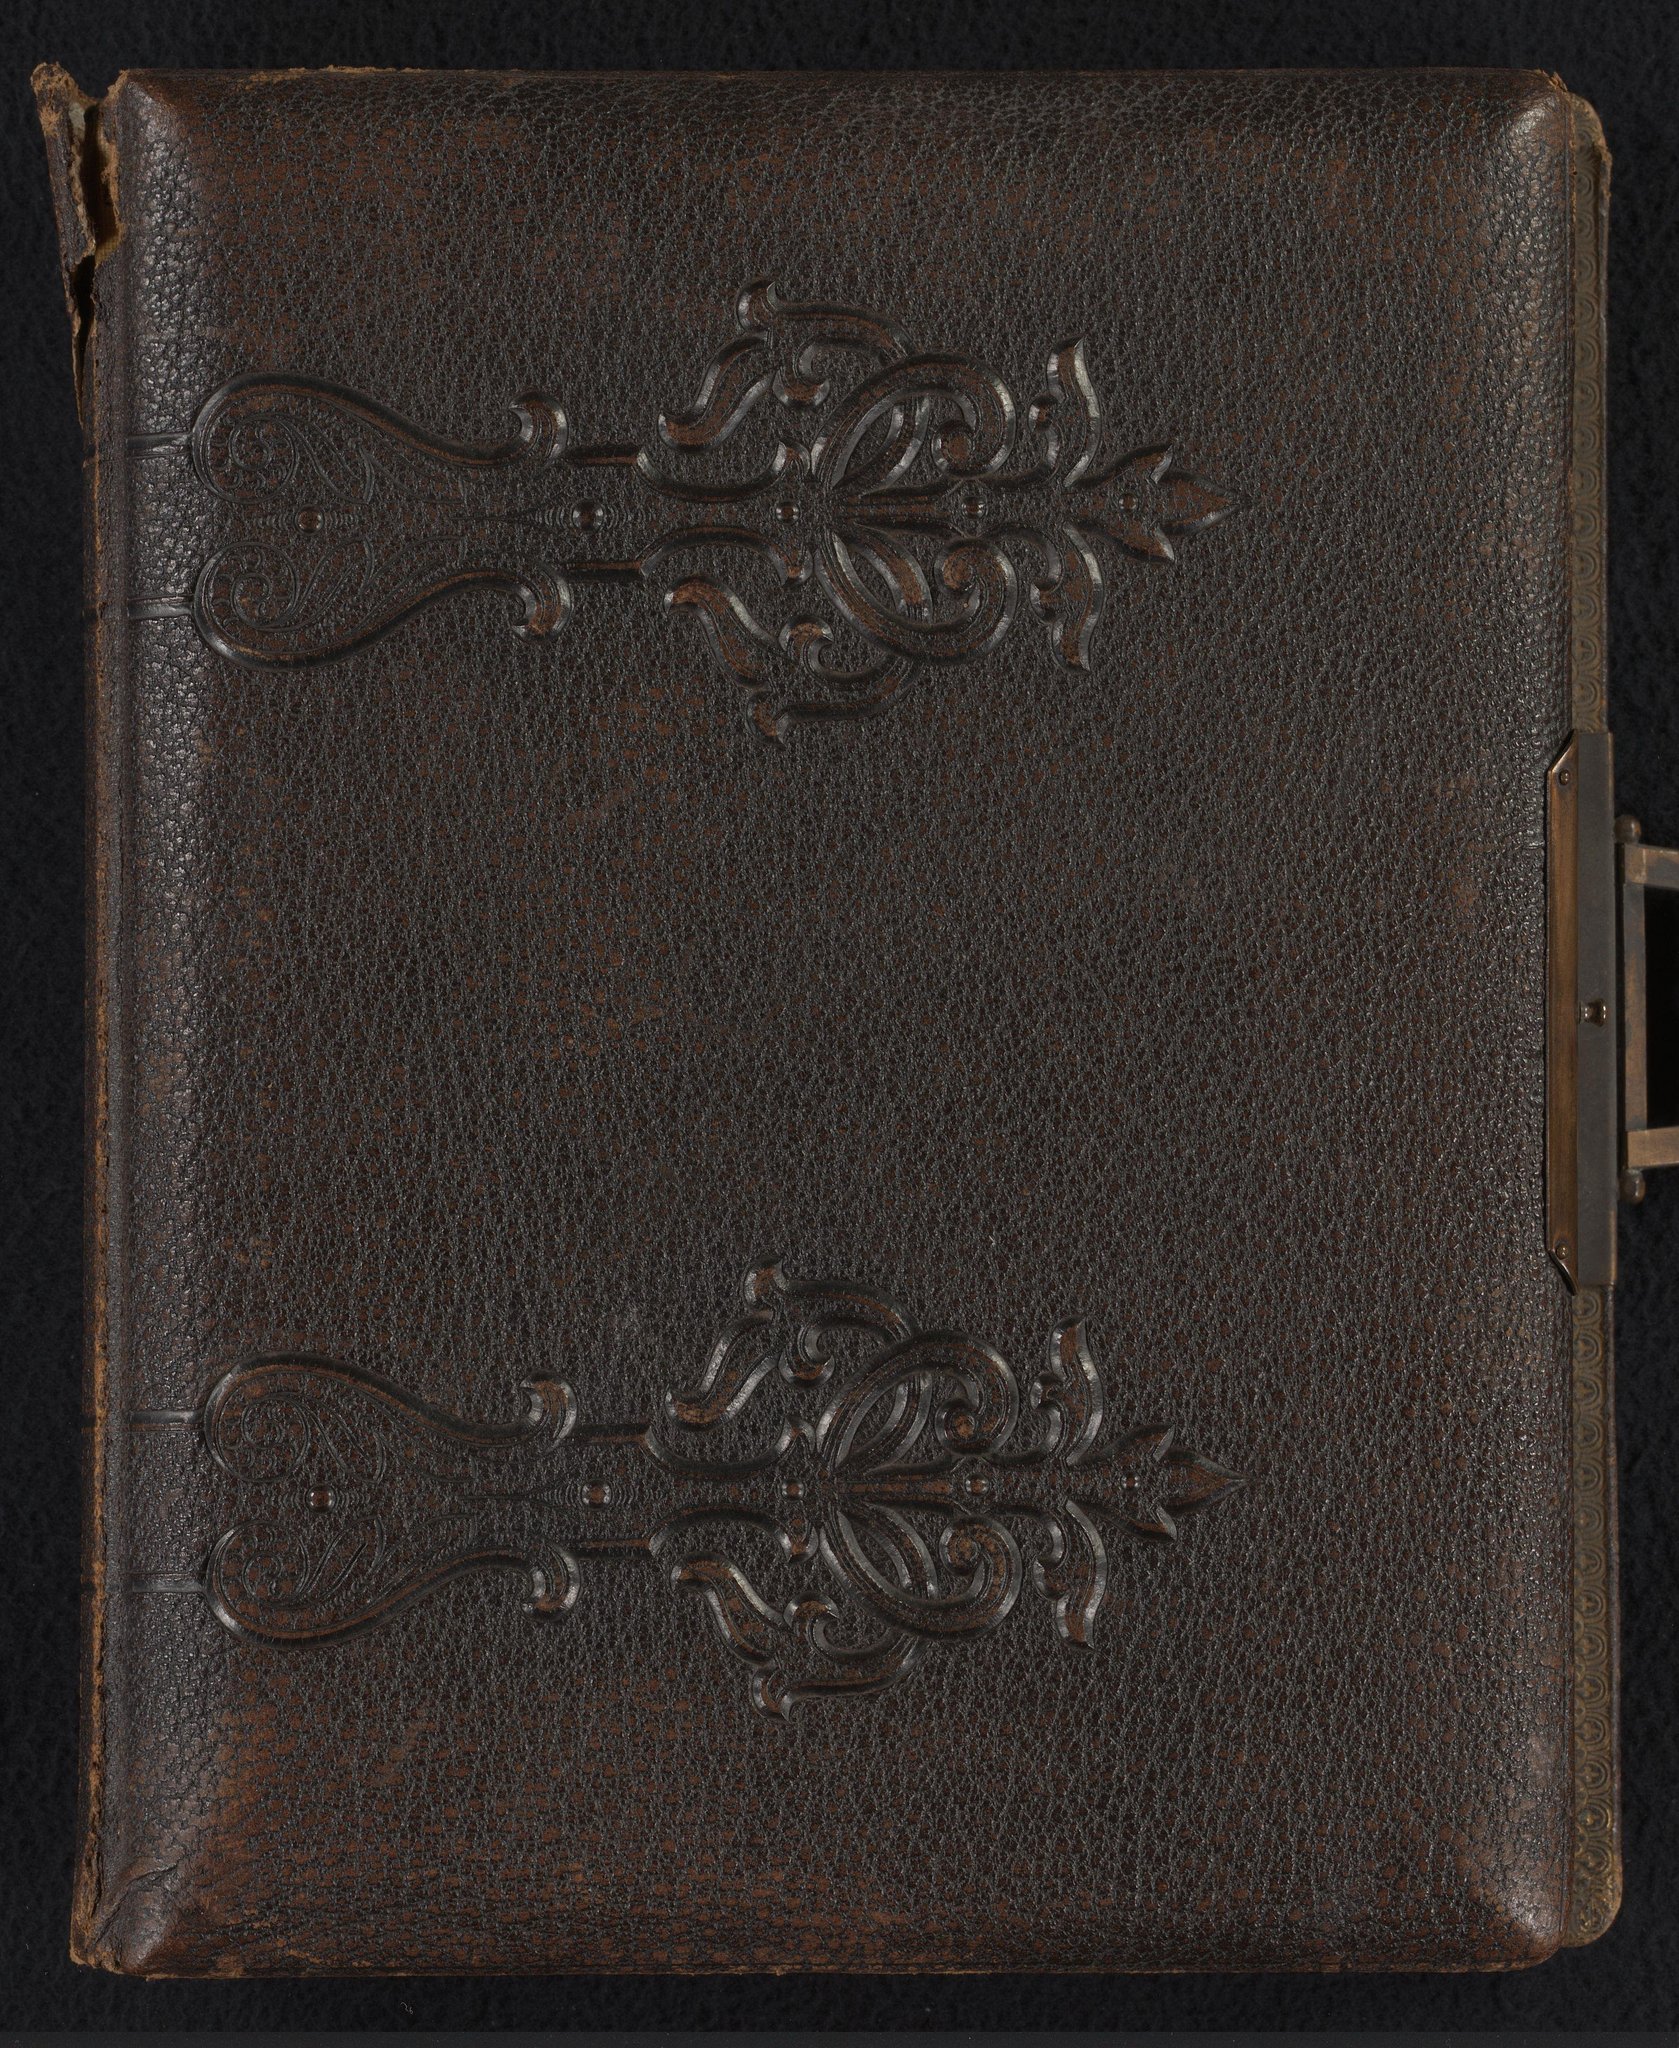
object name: photograph album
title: Engels familiealbum met 45 foto's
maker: Anonymous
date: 1860-1920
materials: cardboard, leather, metal, paper, photographic support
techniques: albumen print, decorated paper, planographic printing, printing block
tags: adult woman, adult man, historical persons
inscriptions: inscription: ‘Dienst/ Verspreide/ Rijkskollekties (...)’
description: Familiealbum met 32 pagina's met in totaal 45 foto's, alle cartes-de-visite of kabinetfoto's. Het album bevat portretten. Op het schutblad reproducties van prenten van een schip, Liverpool en Whitehall.